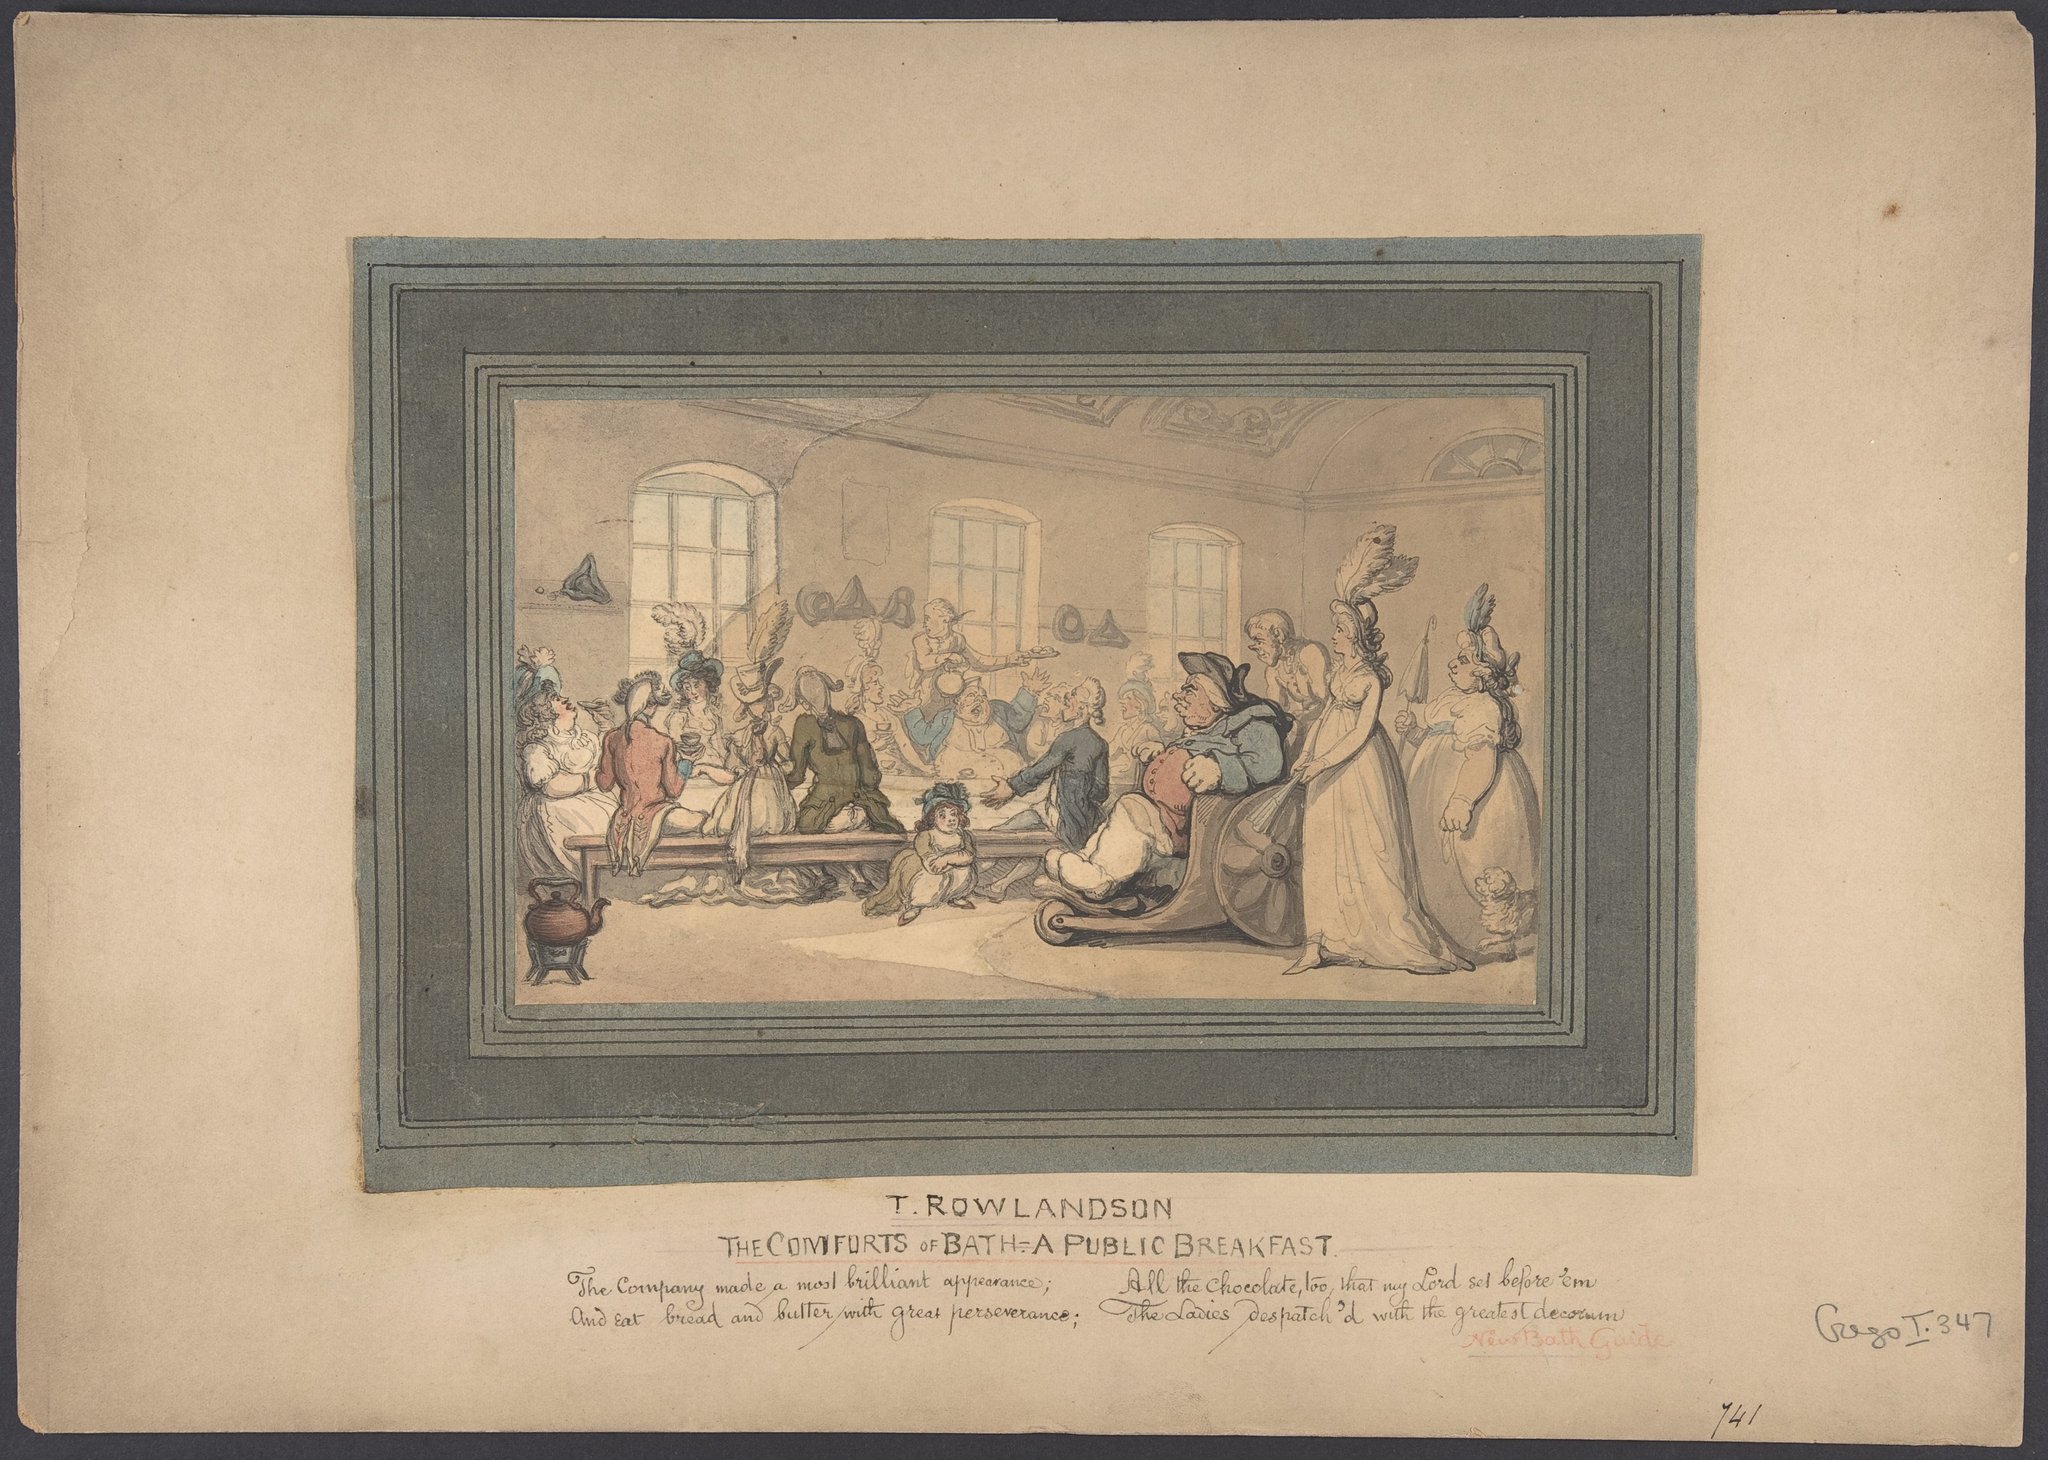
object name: drawing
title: The Comforts of Bath: A Public Breakfast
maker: thomas rowlandson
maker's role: artist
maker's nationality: british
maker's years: 1757-1827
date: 1798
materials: graphite, ink, watercolor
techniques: pen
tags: children,men,women,dining